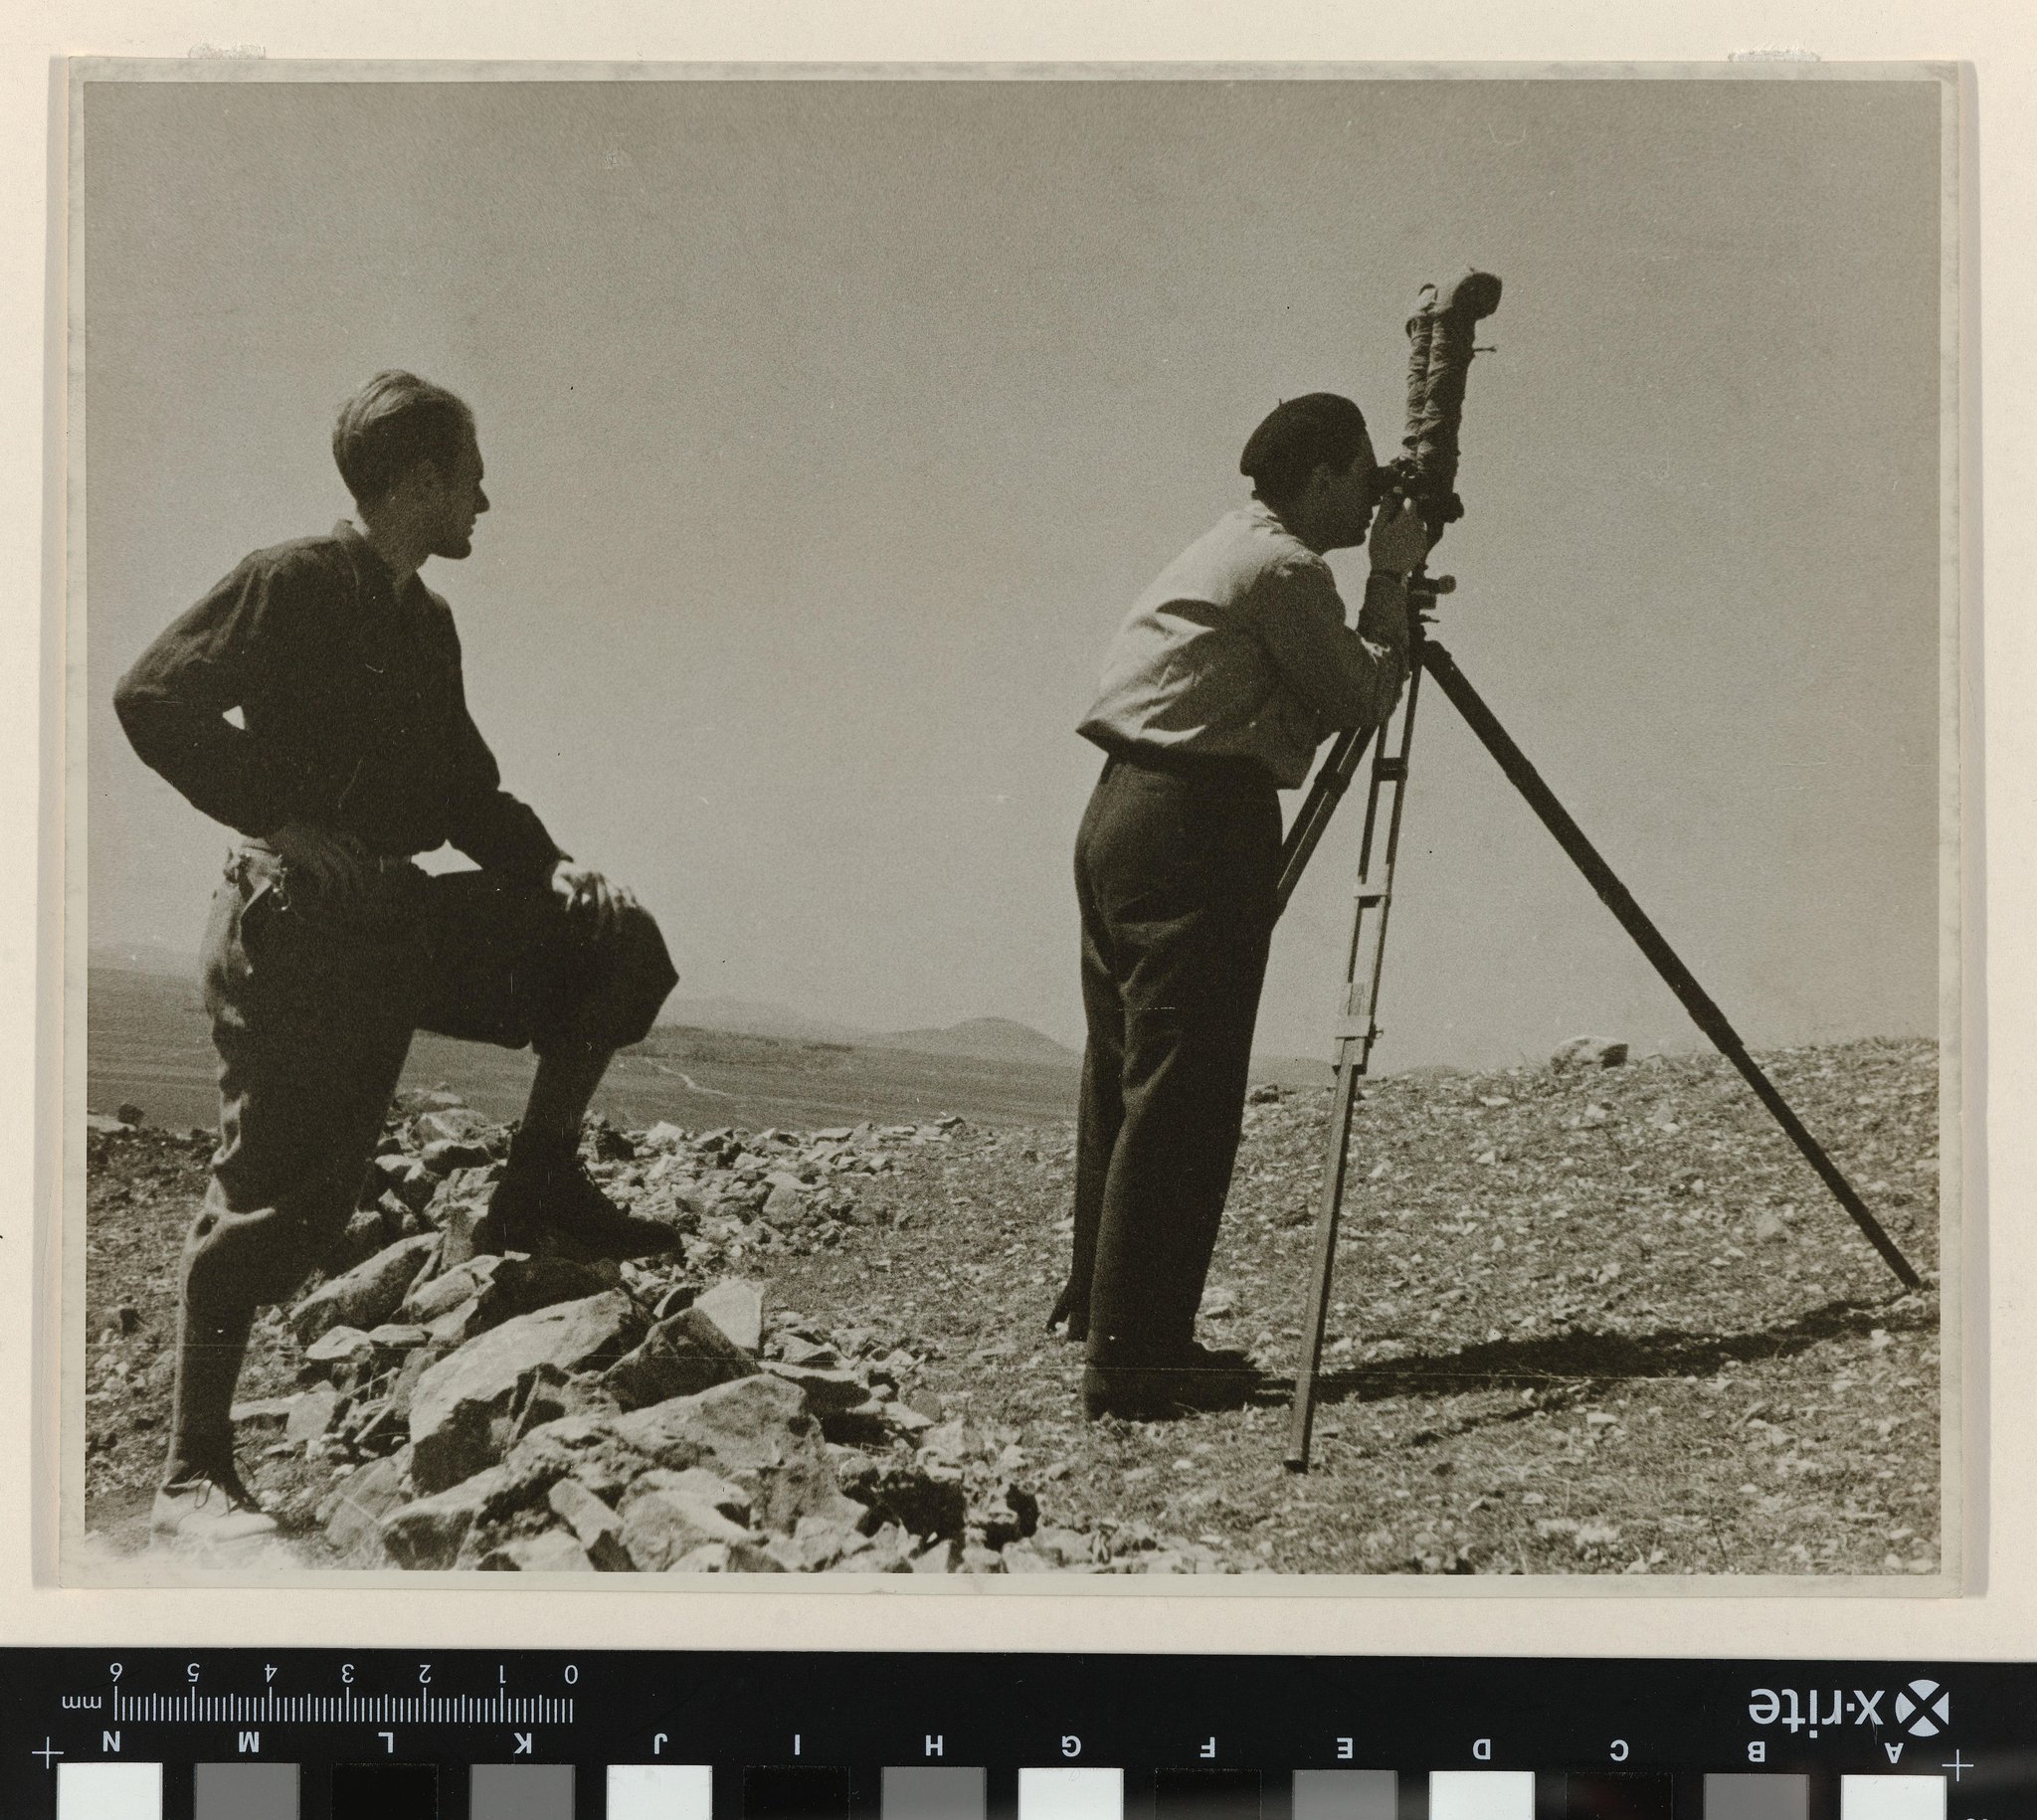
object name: photograph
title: John Fernhout en Joris Ivens achter een veldkijker, China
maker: robert capa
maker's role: fotograaf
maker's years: 1913-1954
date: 1938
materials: paper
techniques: gelatin silver print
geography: china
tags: john fernhout, nijmegen, paris, joris ivens, filming, cinematographer at work - cc - out of doors, binoculars, spy-glass, etc., china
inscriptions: stamp: ‘E 253’